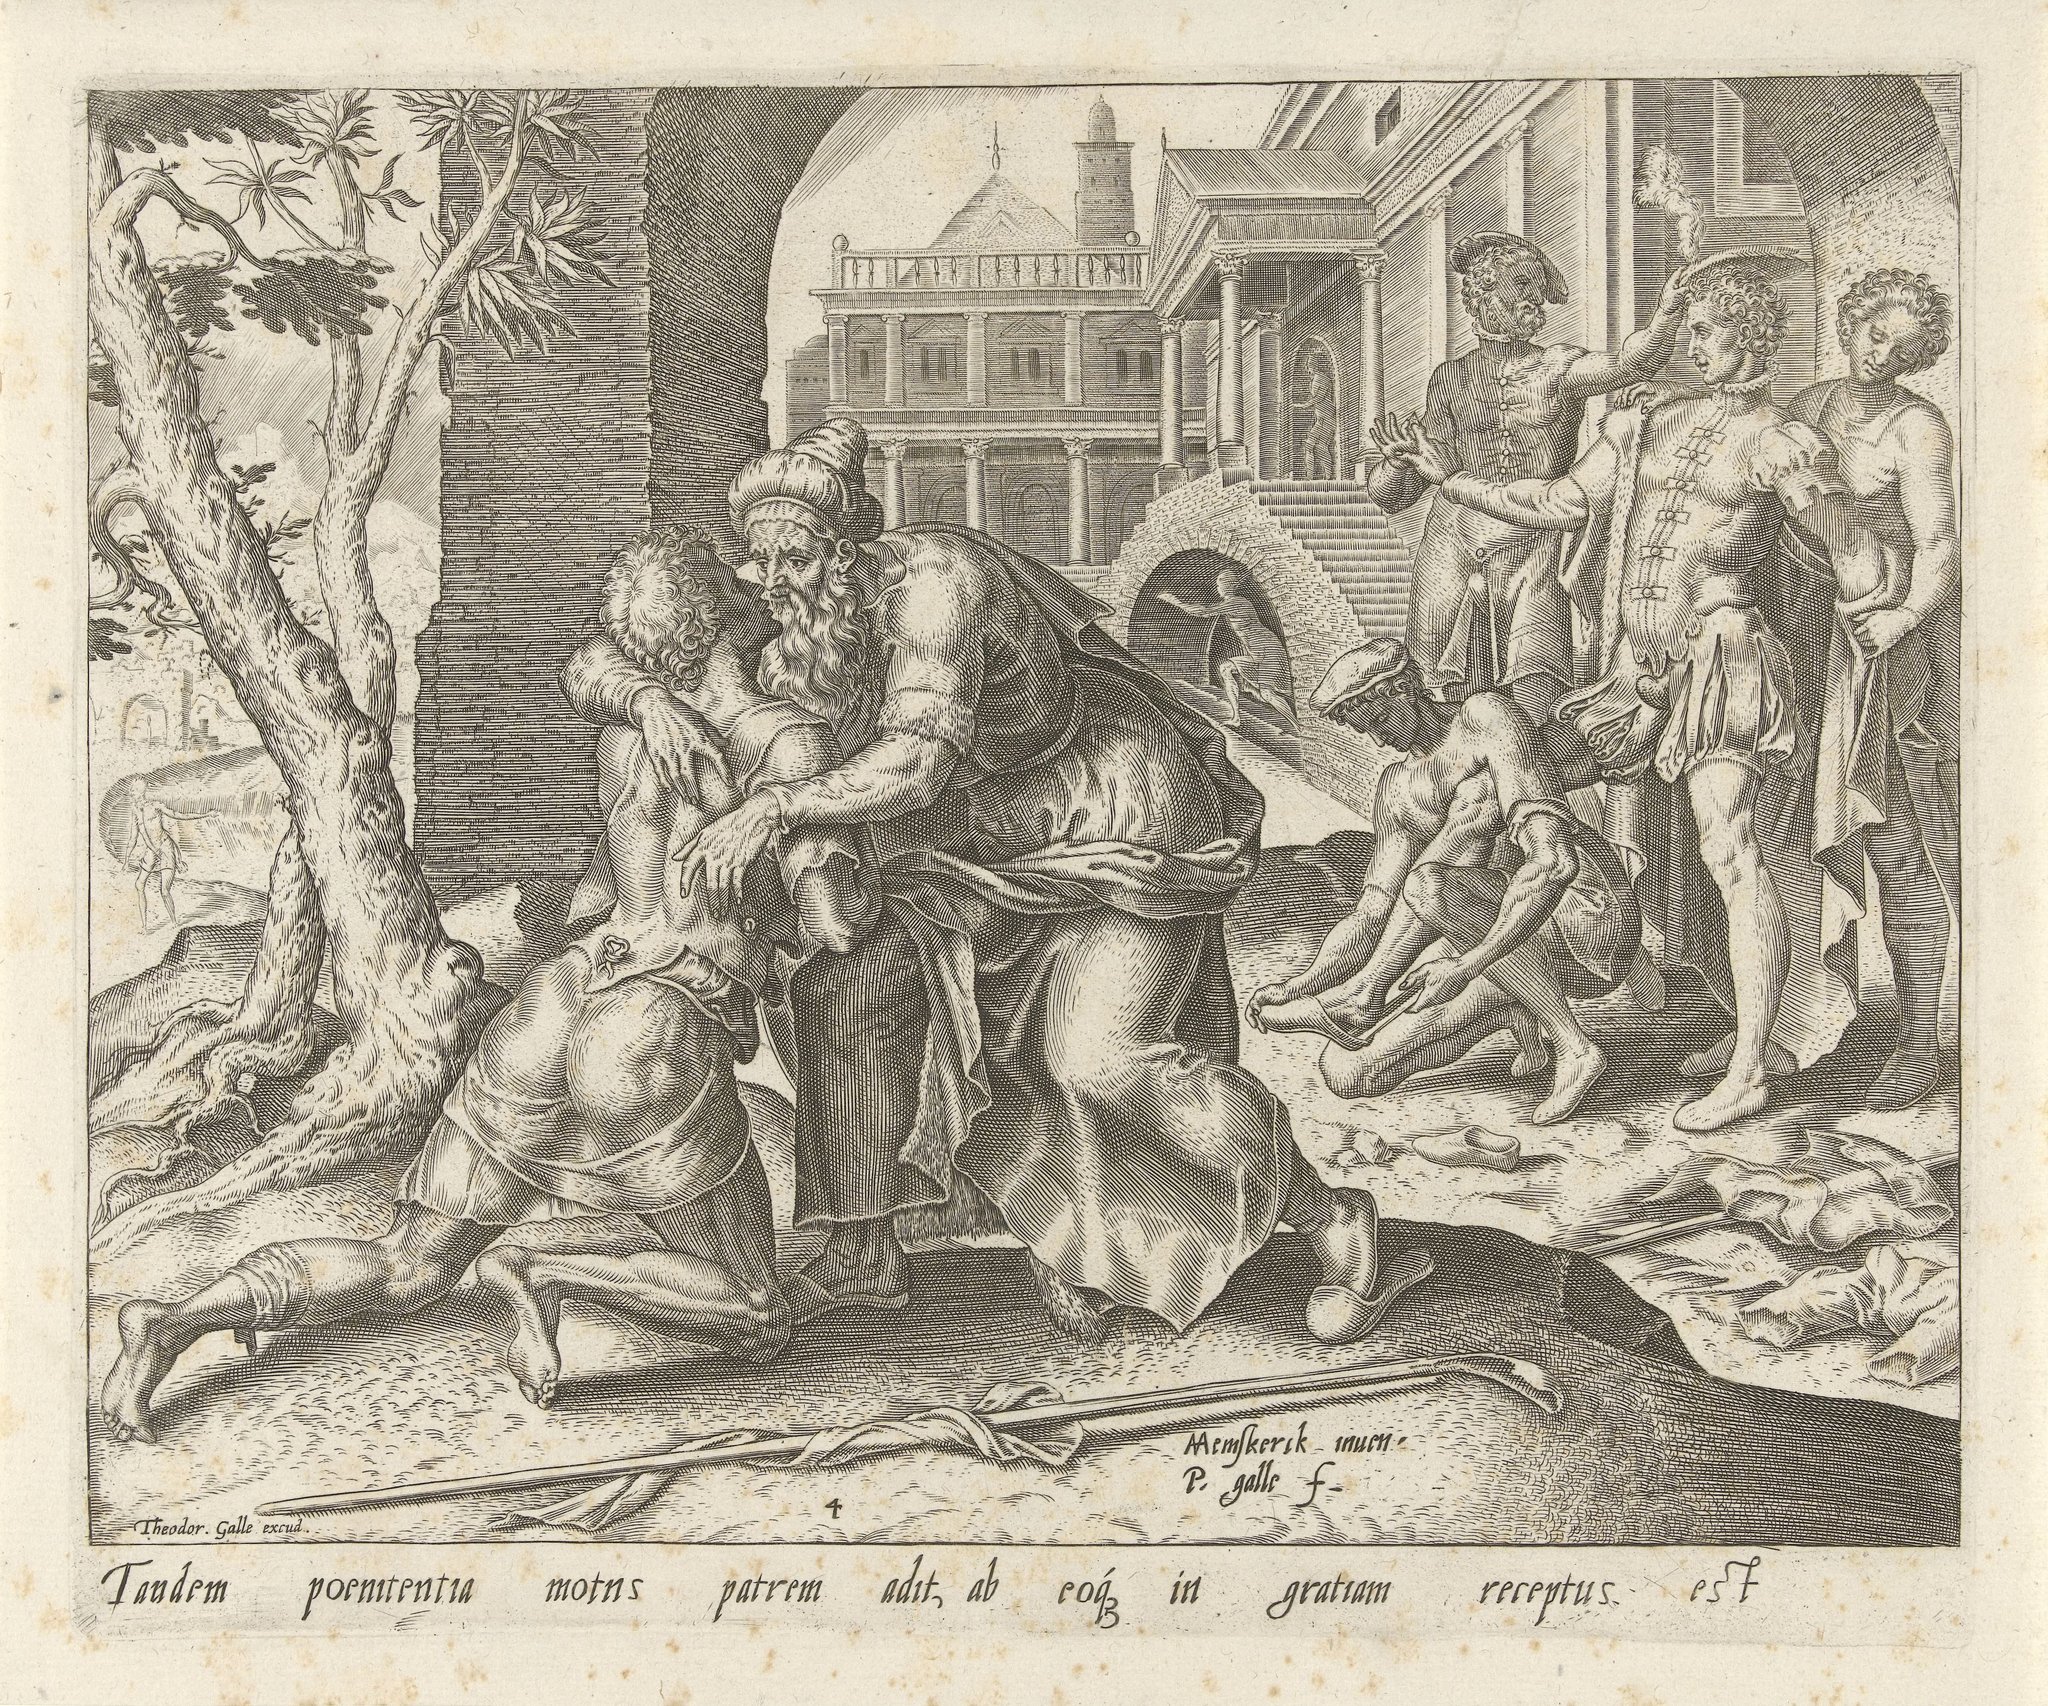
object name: print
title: Gelijkenis van de verloren zoon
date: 1596-1633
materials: paper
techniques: engraving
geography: antwerp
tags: the prodigal son kneels before his father who takes him in his arms, preparations, e.g. the prodigal son is given new robes; slaughtering of the fatted calf; the elder son objects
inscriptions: collector's mark: Lugt 2228, collector's mark: ‘AP 201’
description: De verloren zoon keert terug naar huis en wordt door zijn vader met open armen ontvangen. Zijn broers helpen hem in schone kleren. De oude varkenshoeder kleren liggen rechts op de grond.